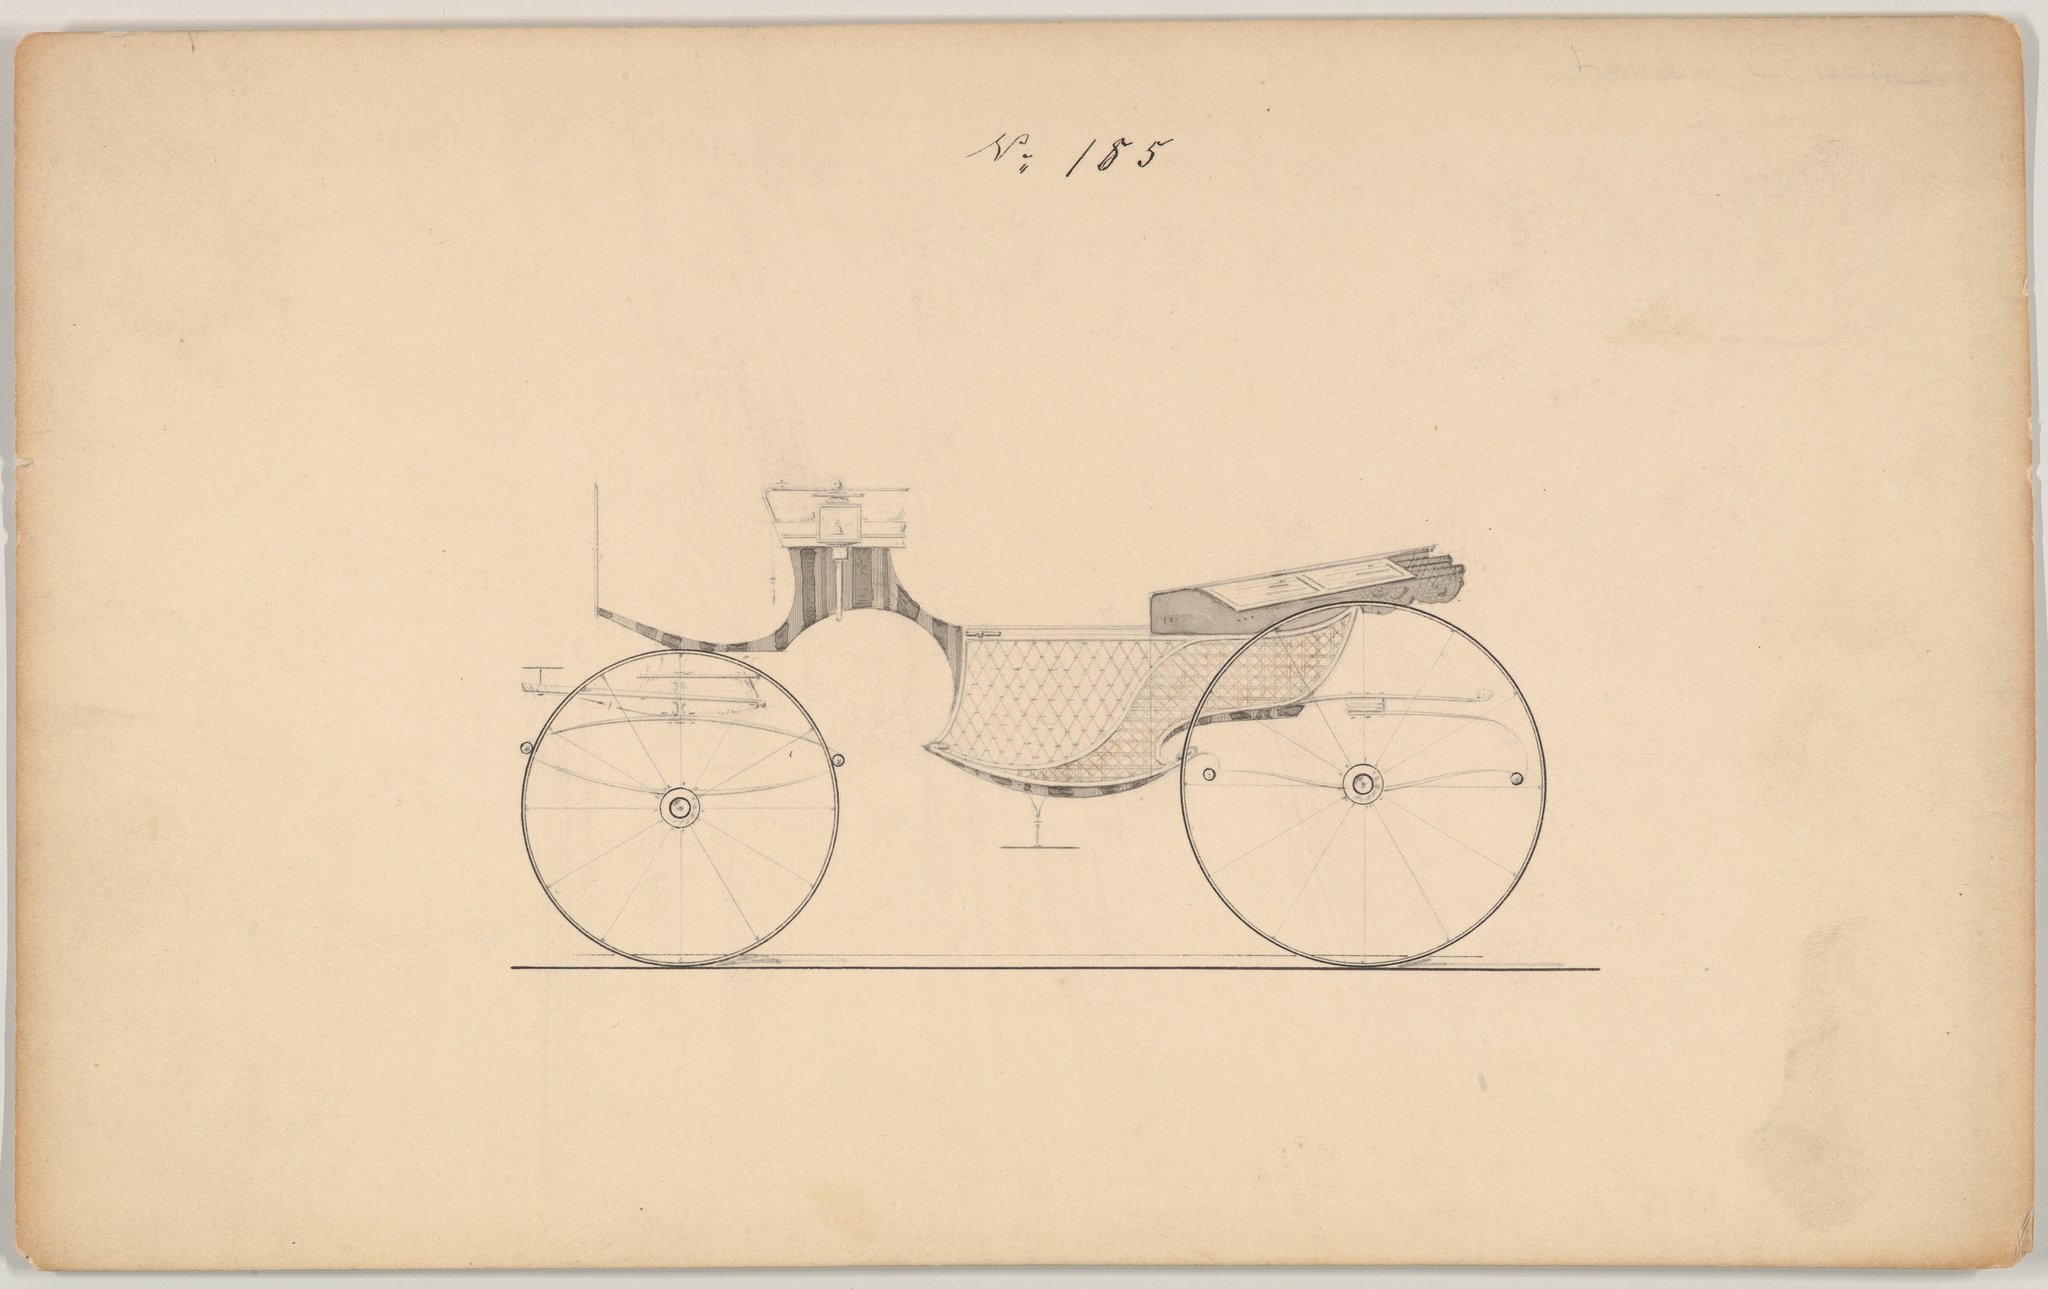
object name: drawing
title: Landaulet #185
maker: brewster & co.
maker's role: manufacturer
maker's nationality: american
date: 1850-1870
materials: graphite, ink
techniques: pen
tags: carriages